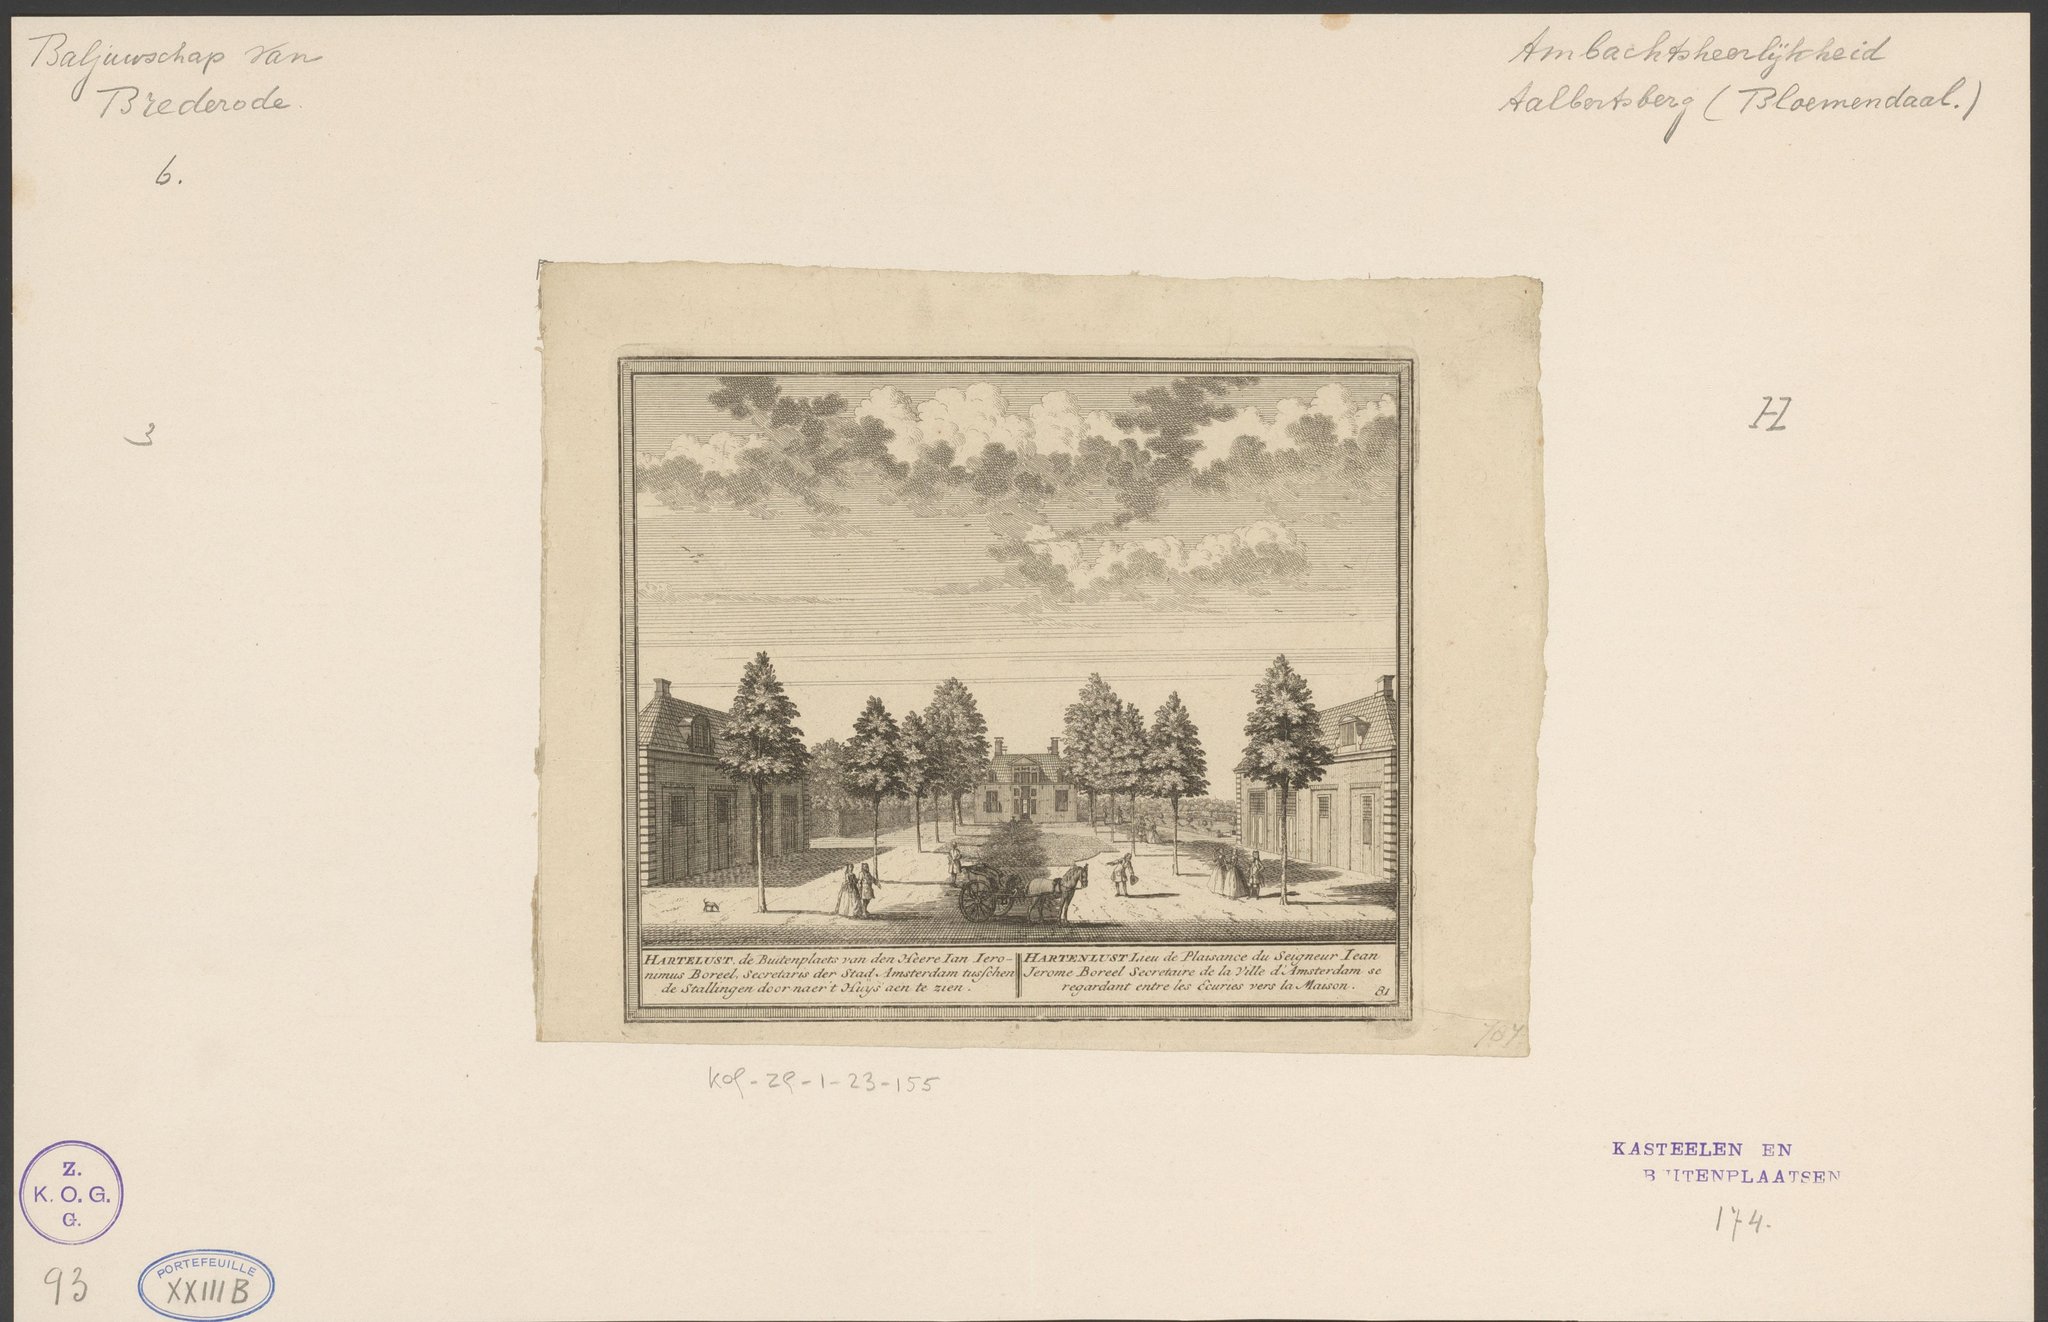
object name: print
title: Hartelust, de Buitenplaets van den Heere jan Jeronimus Boreel, Secretaris der Stad Amsterdam tusschen de Stallingen door naer 't Huys aen te zien / Hartenlust Lieu de Plaisance du Seigneur Jean Jerome Boreel Sectretaire de la Ville d'Amsterdam se regardant entre les Ecuries vers la Maison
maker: hendrik de leth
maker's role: draughtsman, print maker, publisher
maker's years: 1703-1766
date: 1732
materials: paper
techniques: engraving, etching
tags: country-house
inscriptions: stamp, stamp, collector's mark: Lugt 1641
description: Prent waarschijnlijk uit: Broüerius van Nidek, Mattheus. Het Zegenpralent Kennemerlant, vertoont in veele Heerlijke Gezichten. Amsterdam: Leth, Hendrik de en Leth, Andries de, 1732, dl. 2.